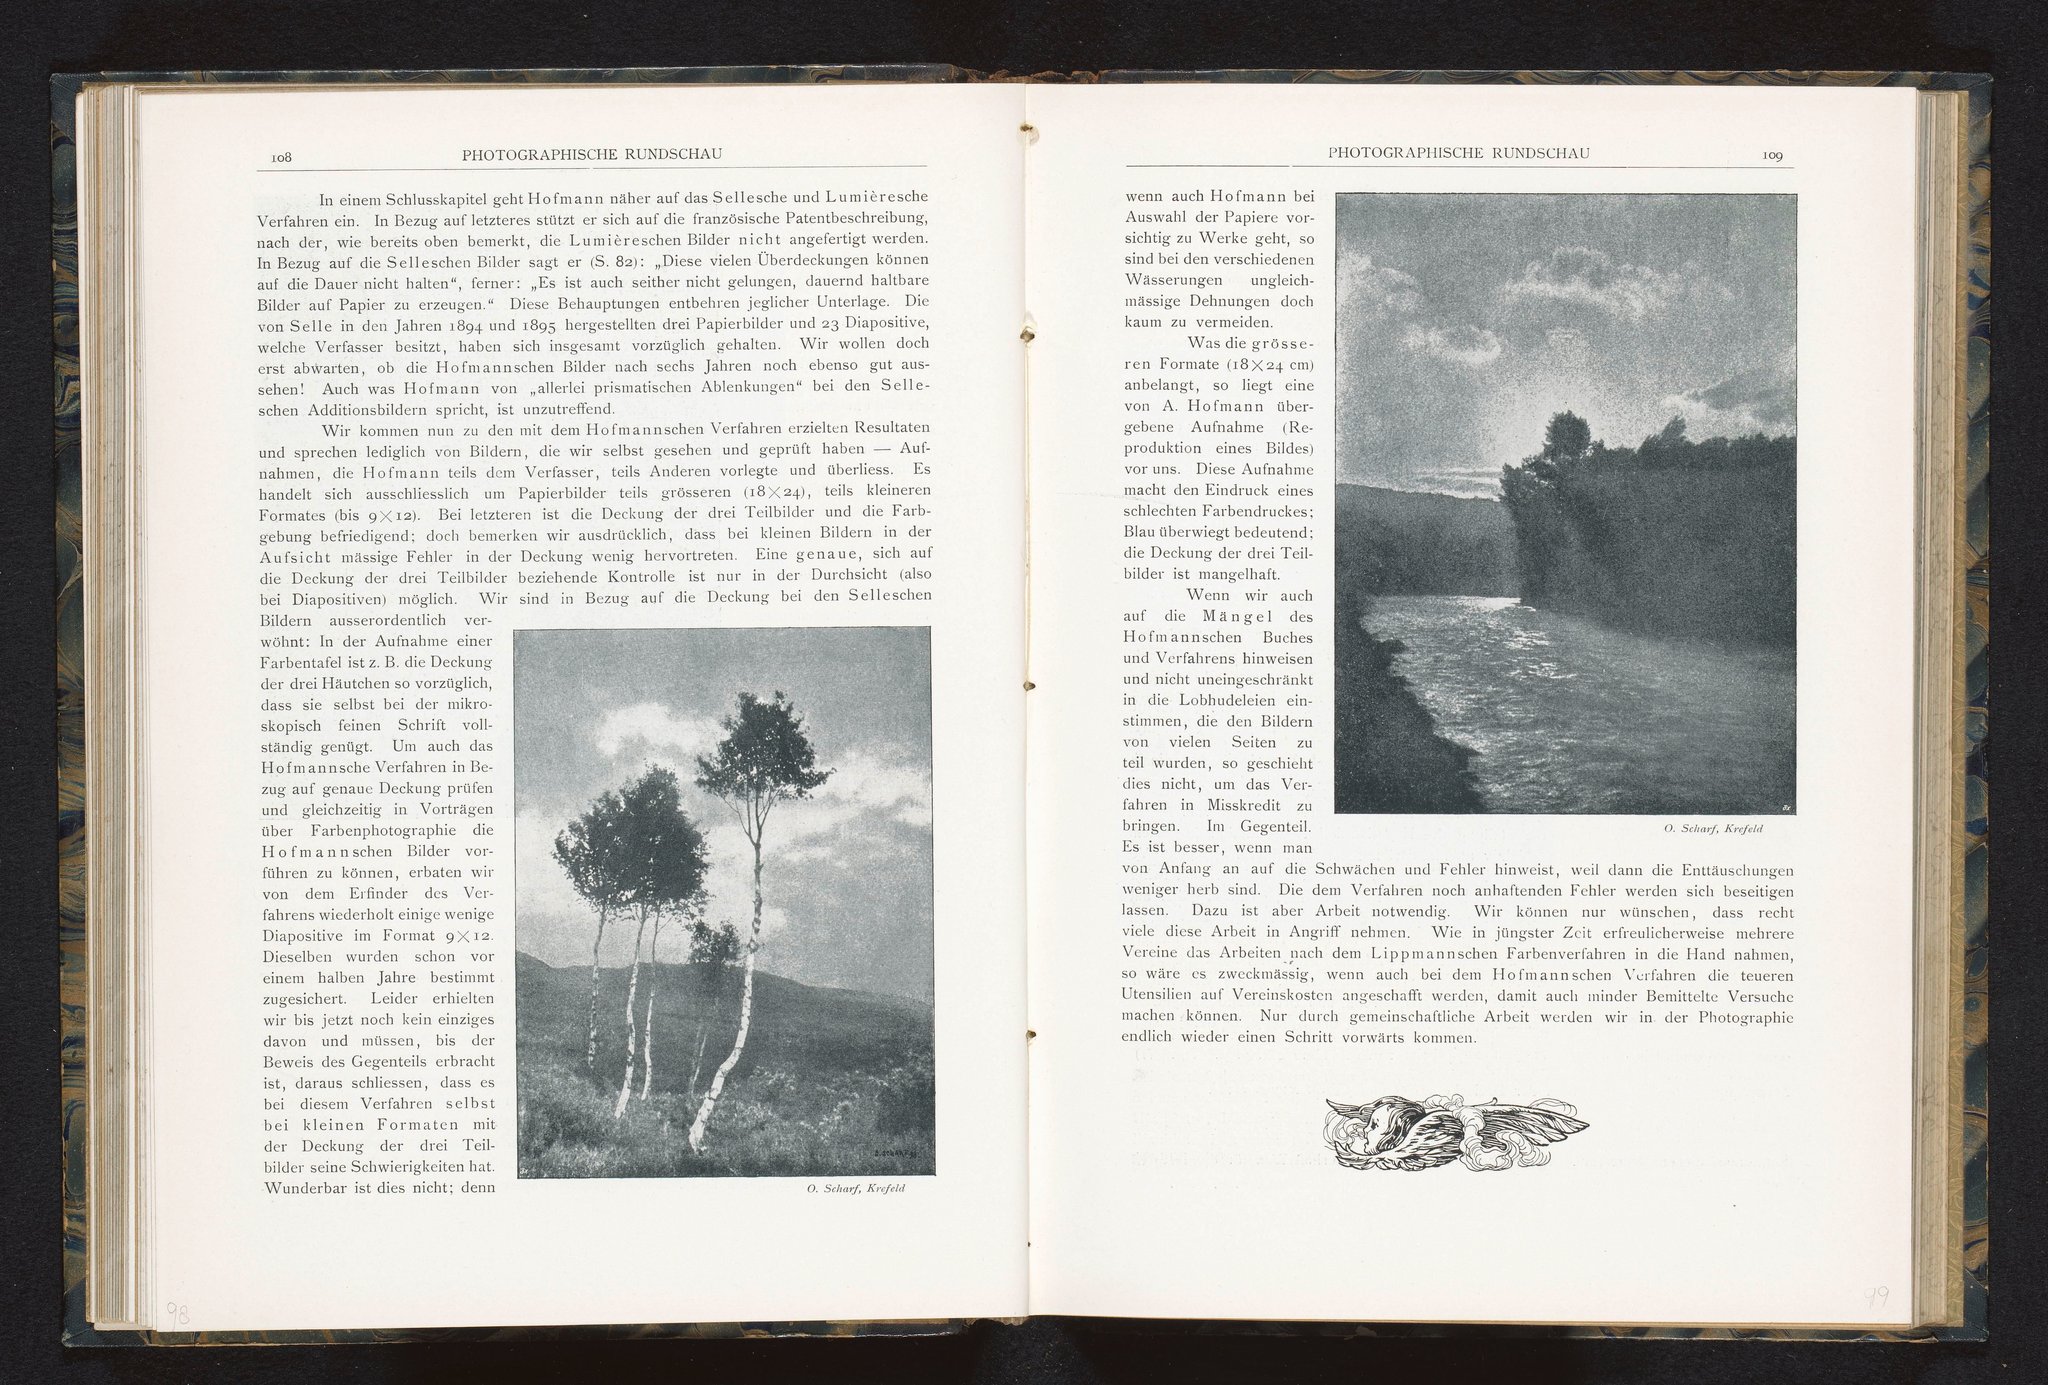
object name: photomechanical print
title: Gezicht op een aantal bomen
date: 1895-1900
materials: paper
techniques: autotype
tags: trees, landscapes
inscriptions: inscription: ‘O. Scharf 99’, monogram: ‘BX’